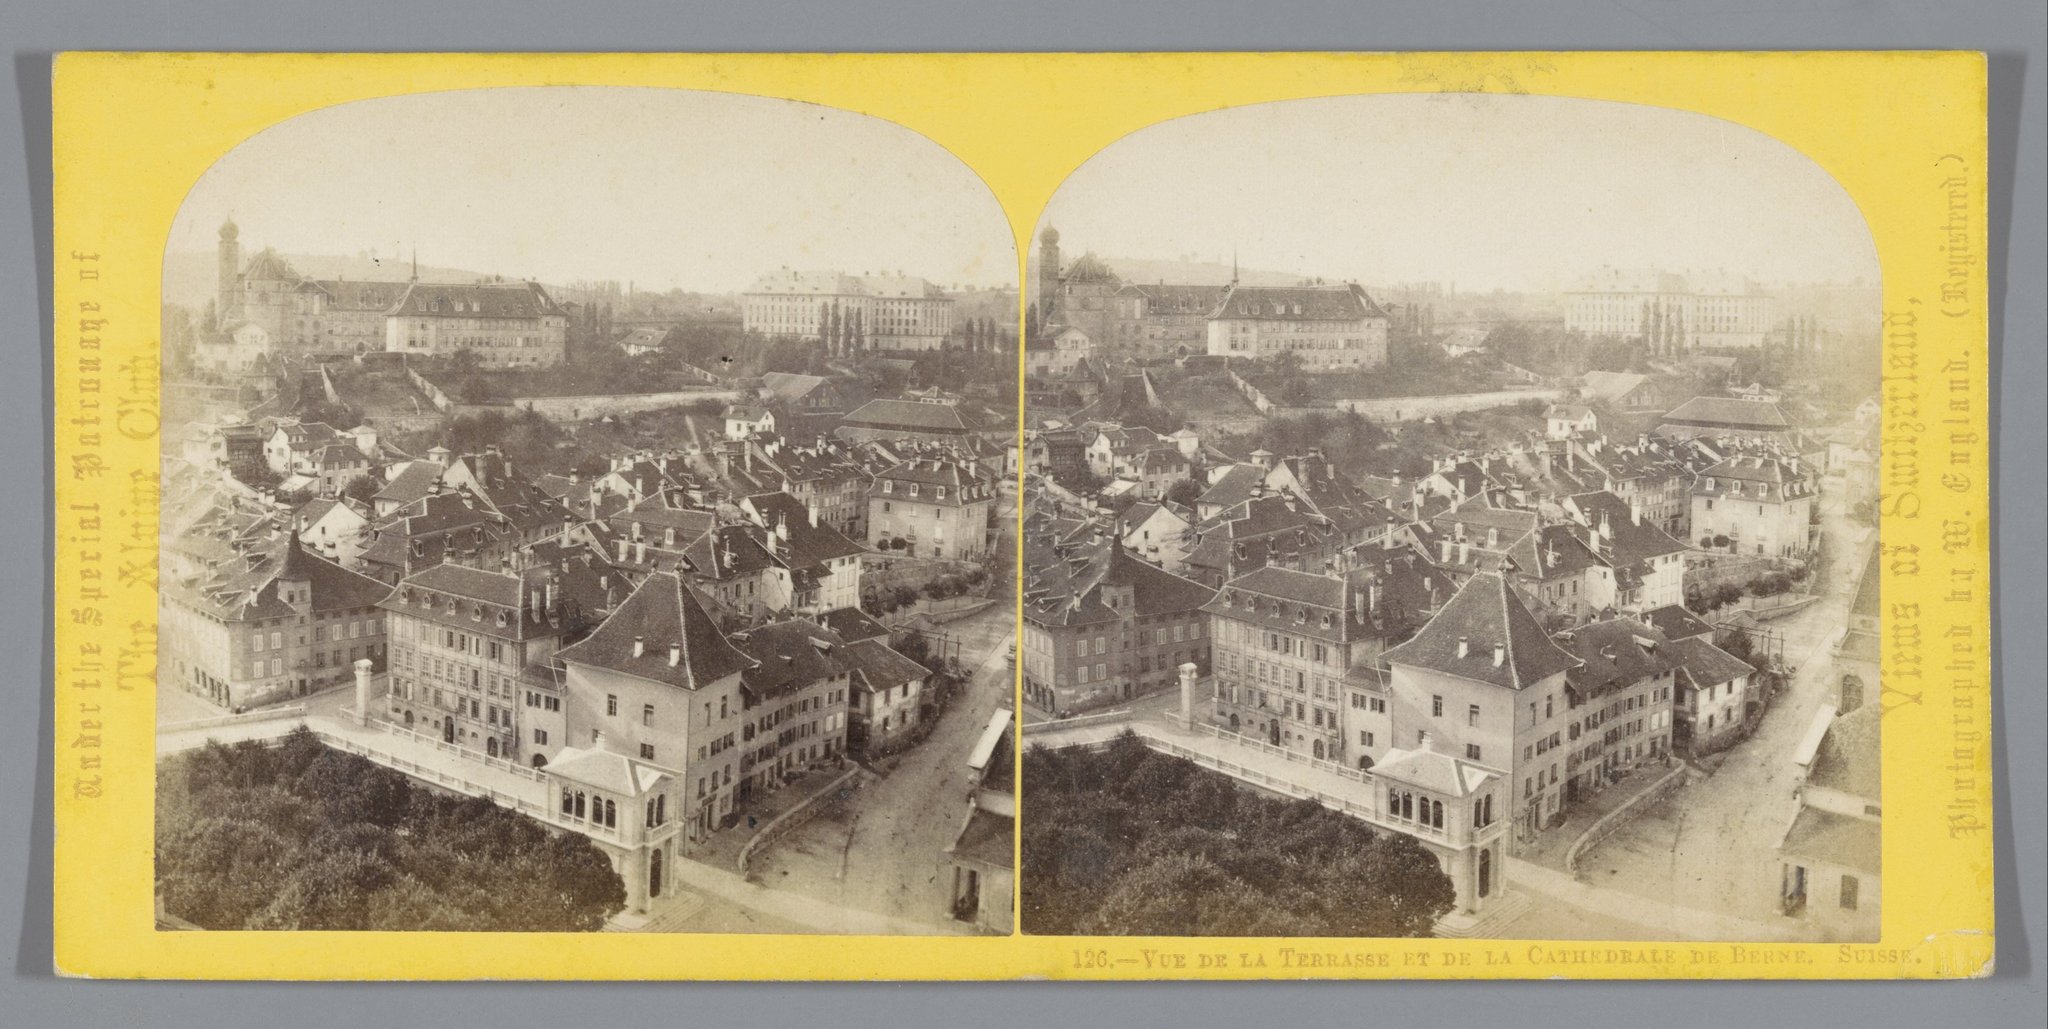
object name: stereograph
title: Vue de la Terrasse et de la Cathédrale de Berne. Suisse.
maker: william england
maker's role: fotograaf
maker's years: 1816-1896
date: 1850-1880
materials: cardboard, photographic support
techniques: albumen print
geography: fribourg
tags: city-view in general; 'veduta'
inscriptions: number: ‘126.’, inscription: ‘Views of Switzerland, photographed by W. England. (Registered) Under the Special Patronage of the Alpine Club.’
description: De titel op object vermeldt de locatie als Bern, dit is echter Fribourg.